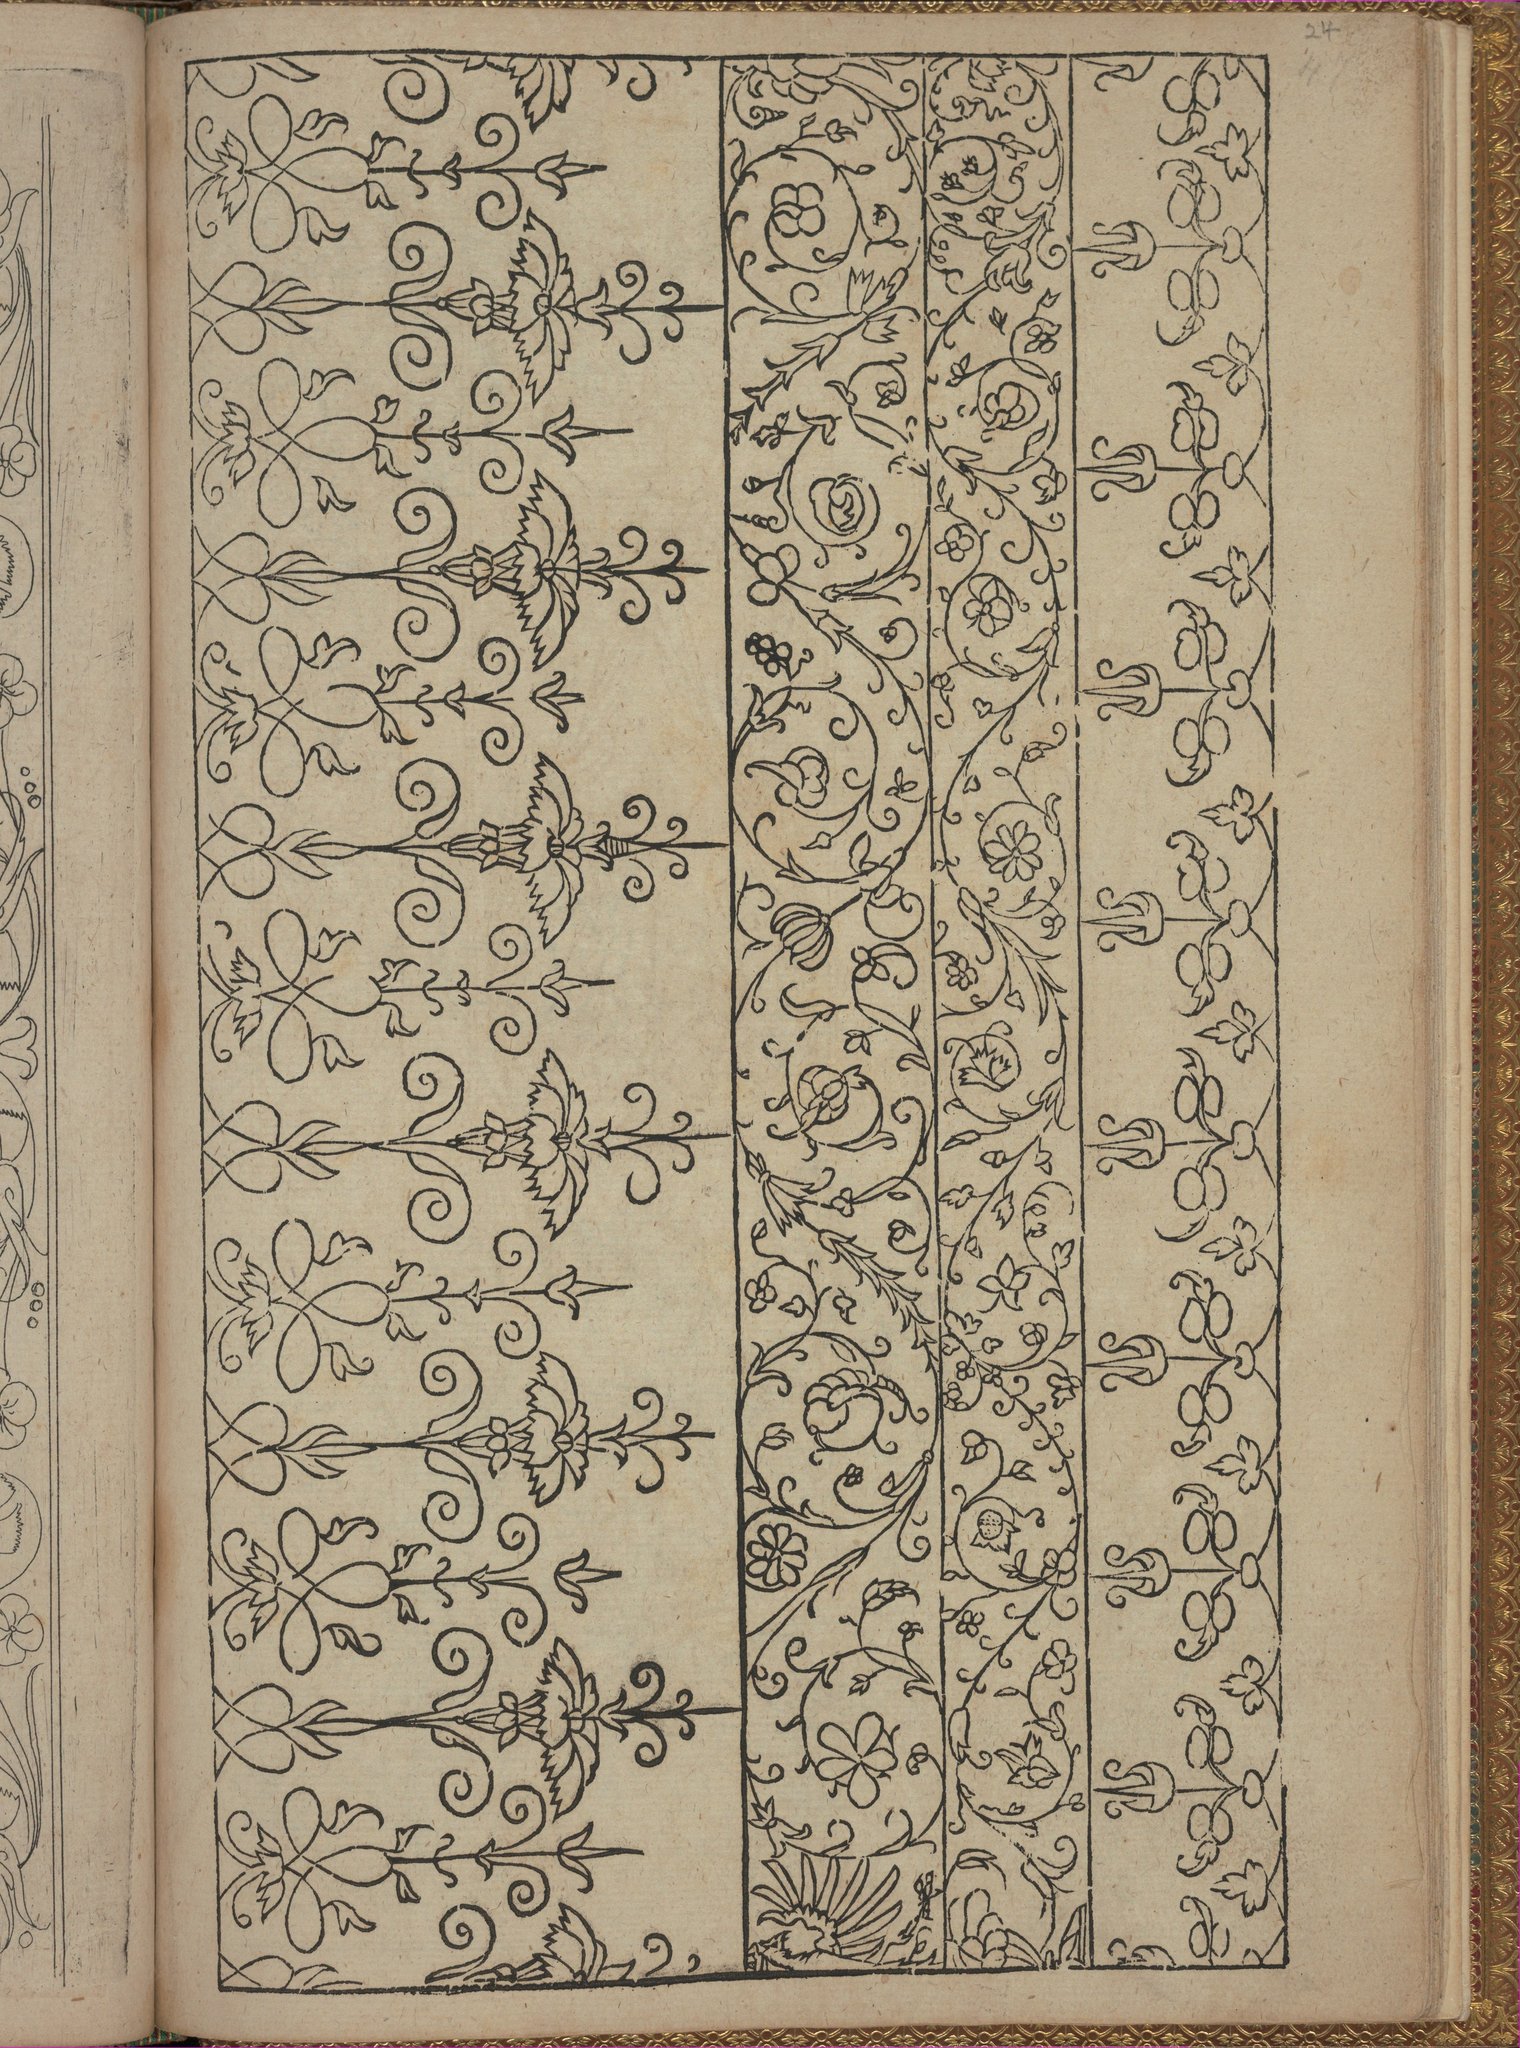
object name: book print ornament architecture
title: New Modelbüch (Page 24r)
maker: andreas bretschneider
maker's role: designer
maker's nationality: german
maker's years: 1573-1645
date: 1615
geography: germany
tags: ornament